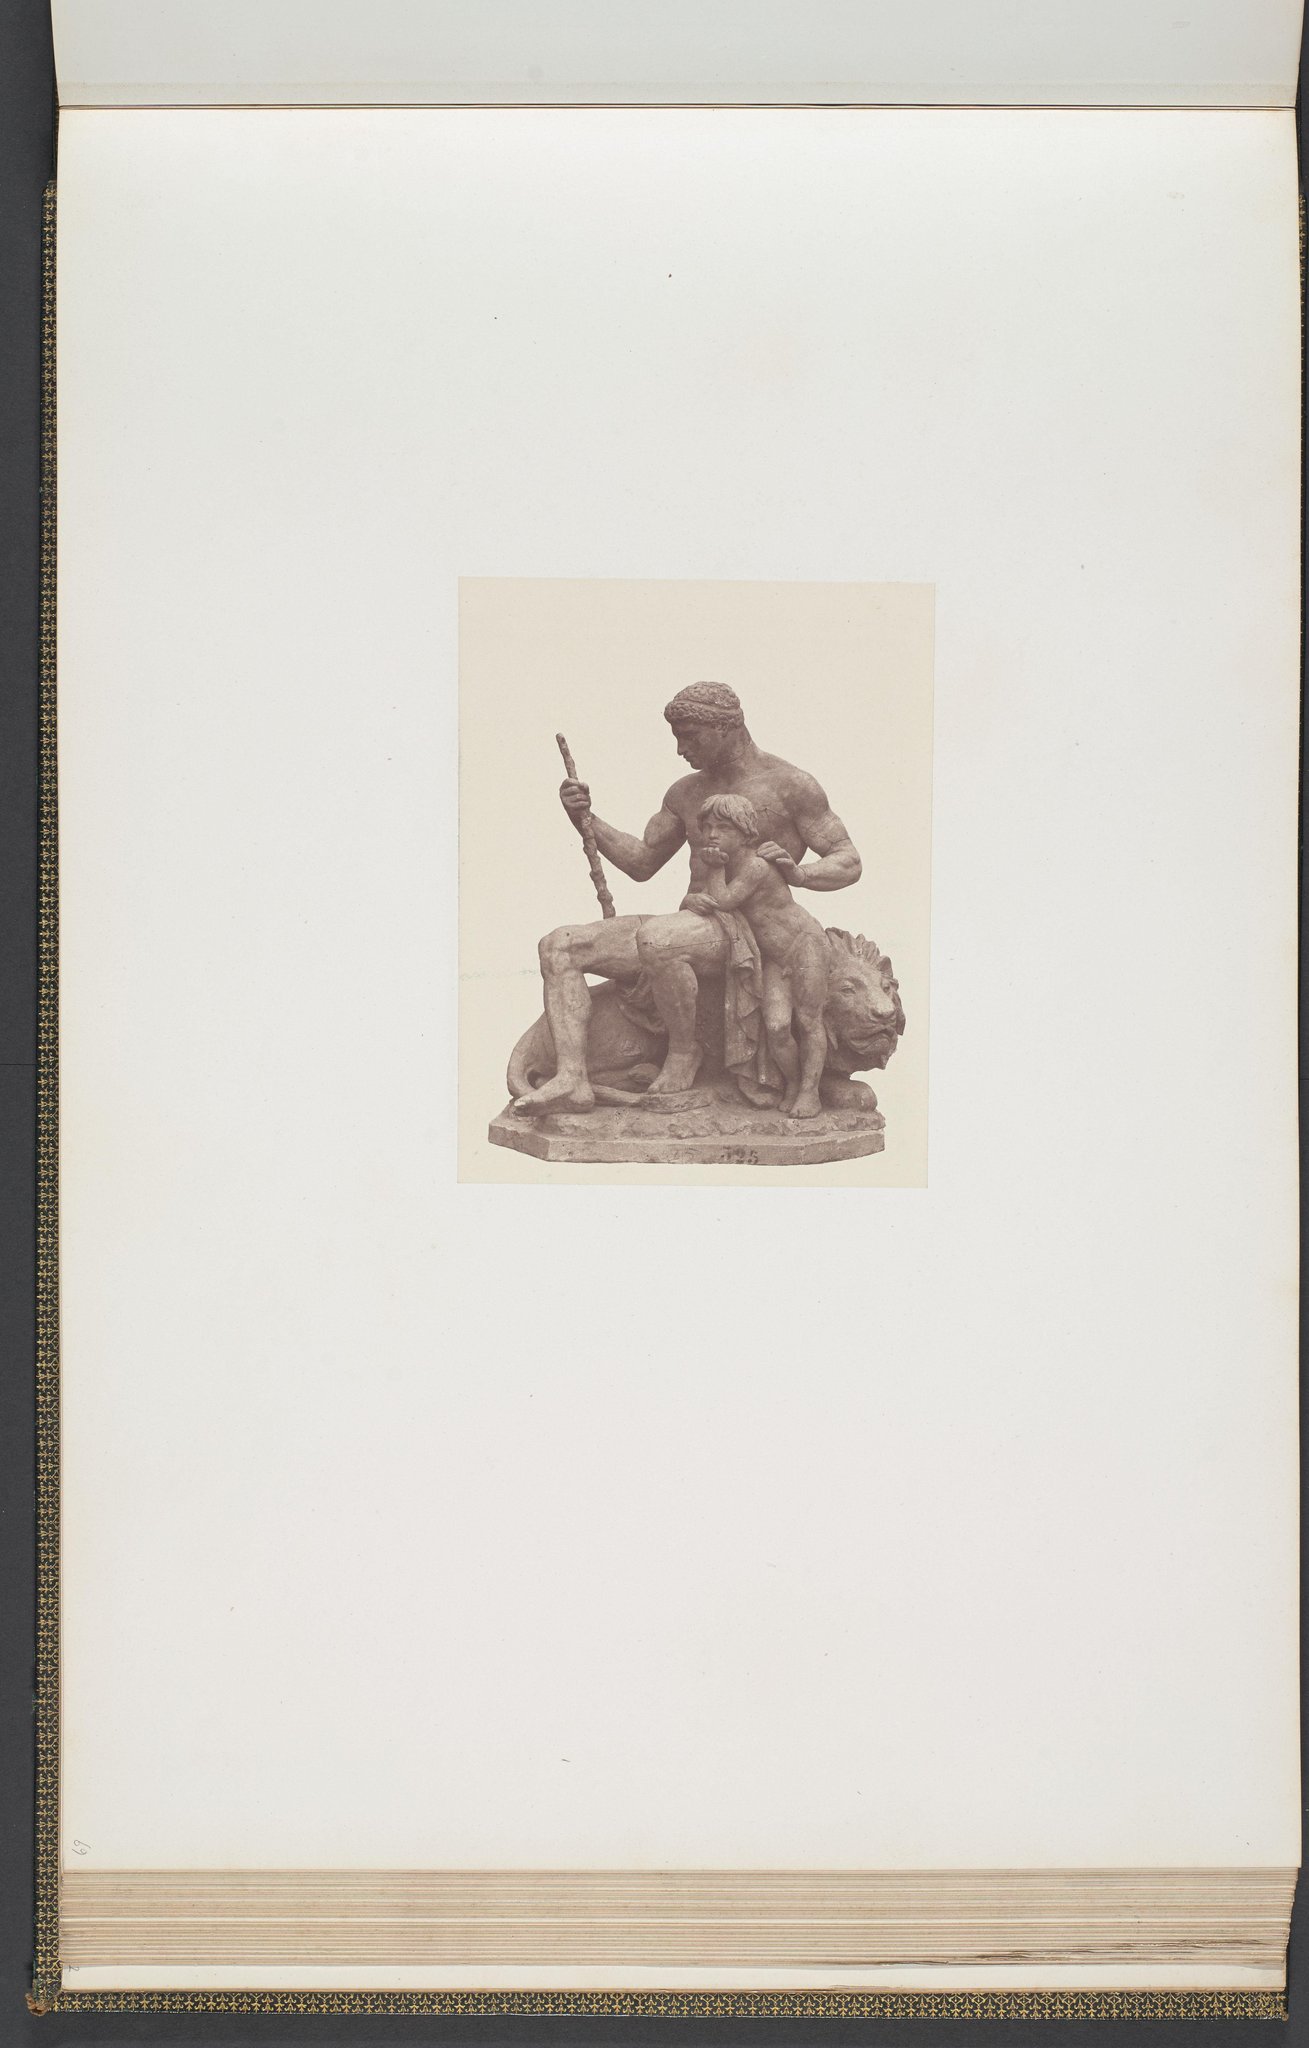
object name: photograph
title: Gipsmodel voor beeldhouwwerk op het Palais du Louvre: "La Force" door Antoine-Louis Barye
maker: édouard denis baldus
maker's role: fotograaf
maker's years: 1813-1889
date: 1855-1857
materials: paper, photographic support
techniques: salted paper print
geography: paris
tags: piece of sculpture, reproduction of a piece of sculpture, permanent exhibition, museum, paris, tuileries palace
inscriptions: number: ‘325’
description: Onderdeel van Réunion des Tuileries au Louvre 1852-1857, album 2.